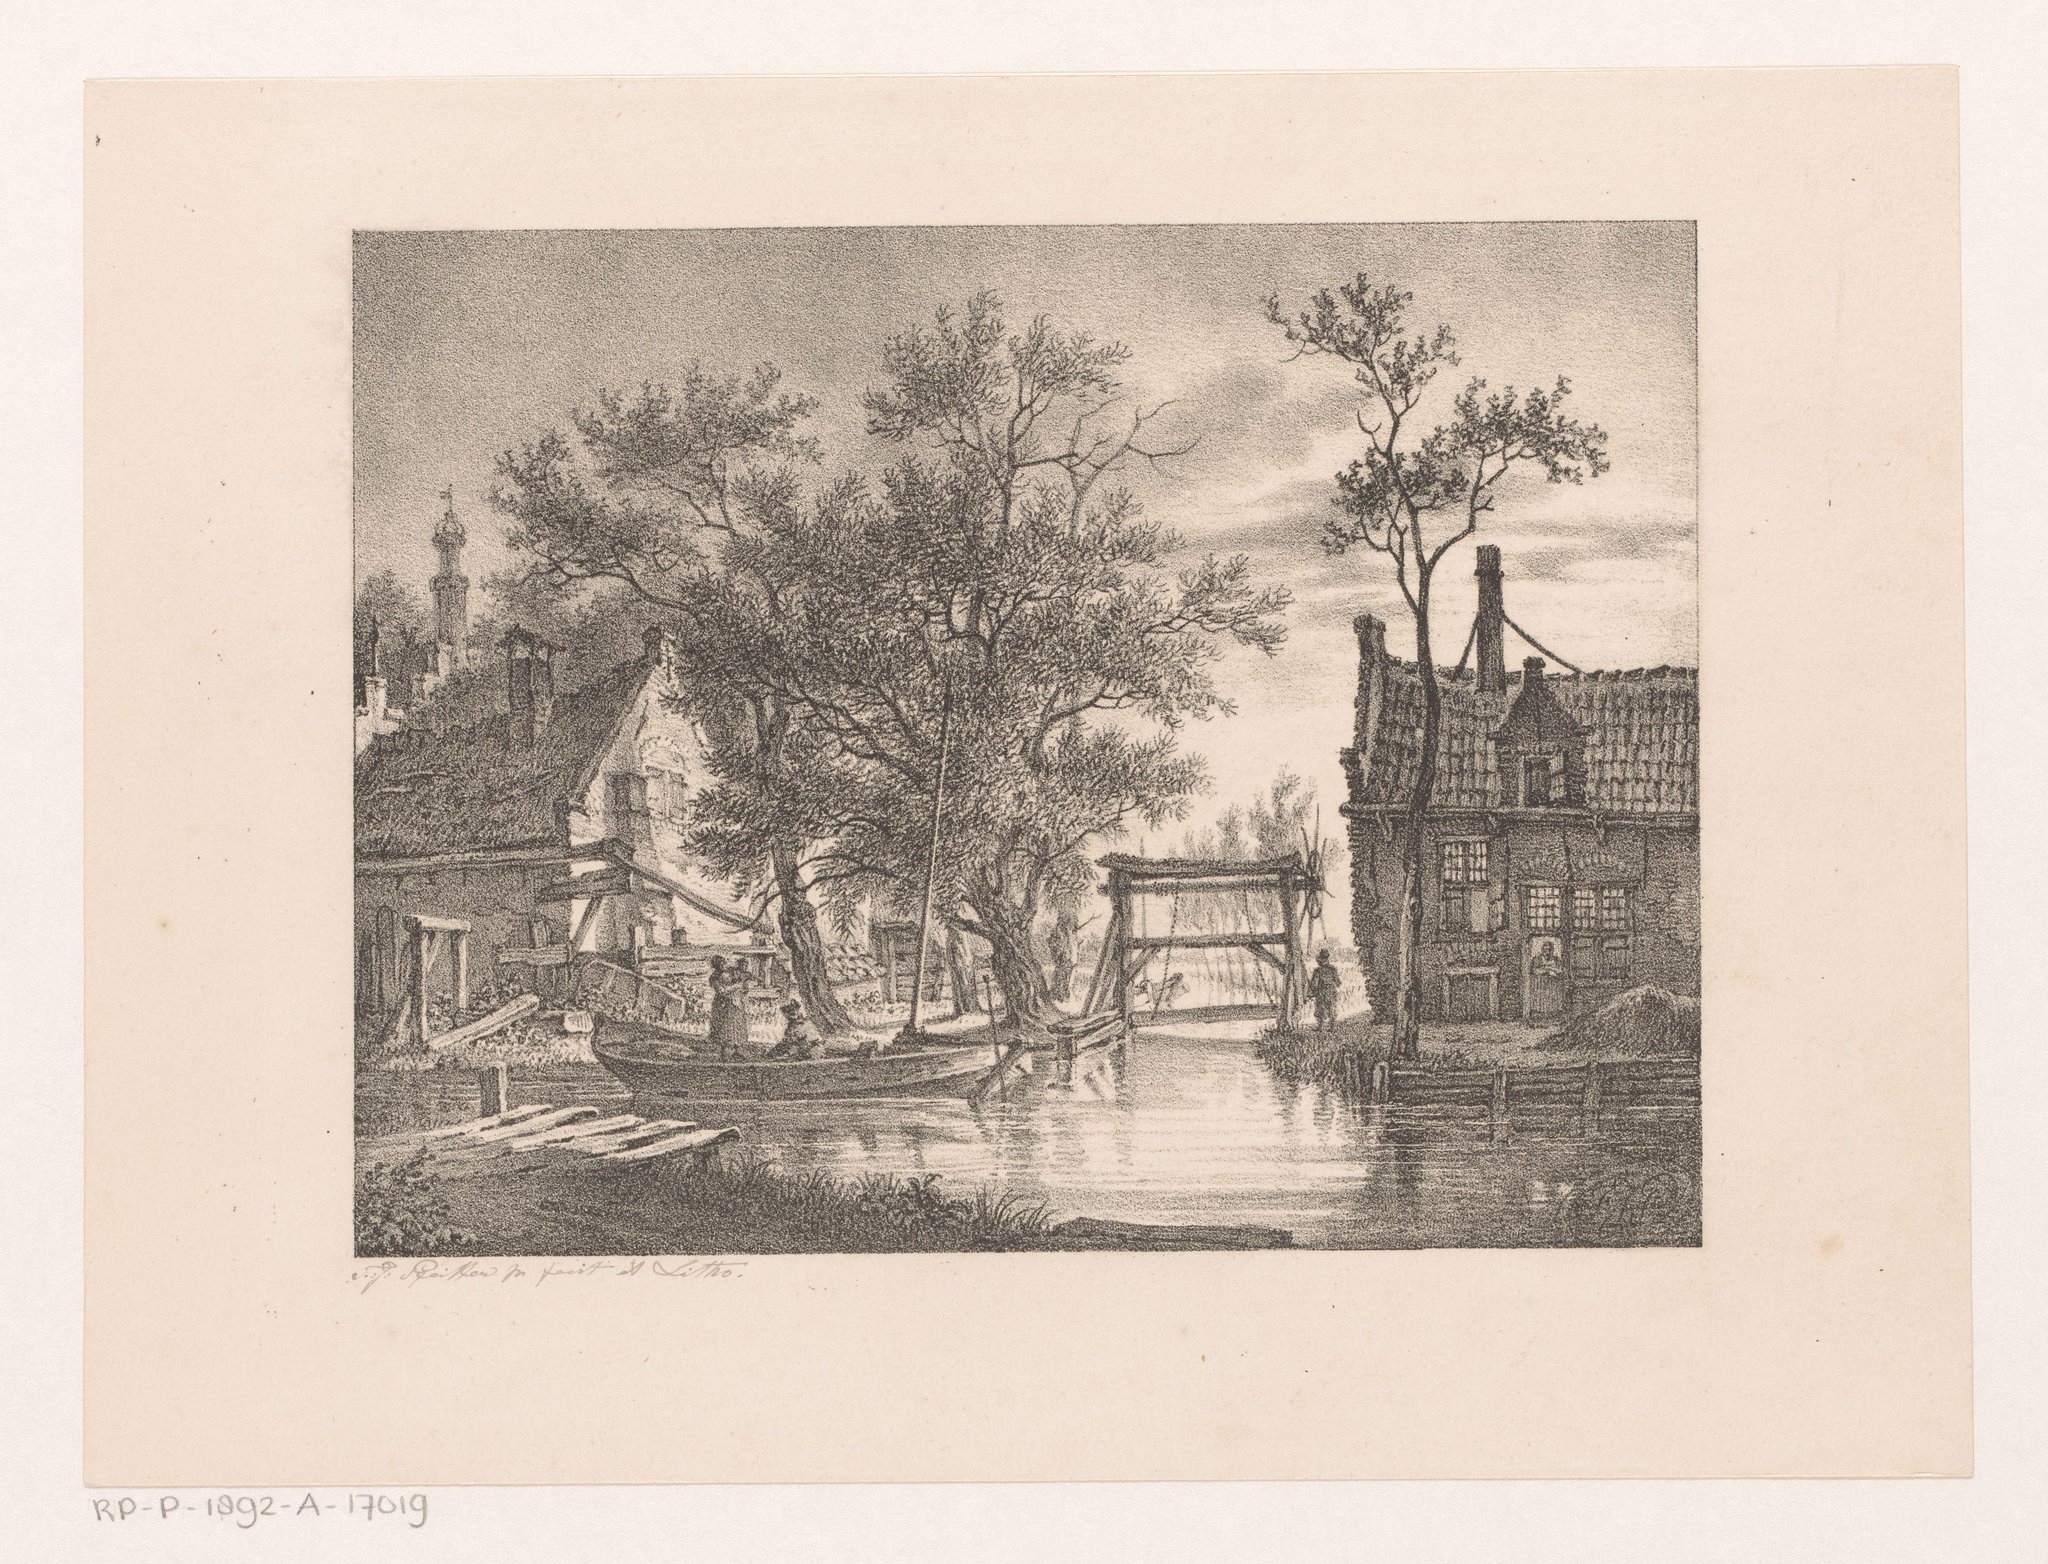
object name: print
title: Huizen aan een wetering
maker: françois joseph pfeiffer (ii)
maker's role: draughtsman, print maker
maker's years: 1778-1835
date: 1809-1835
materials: paper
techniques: lithograph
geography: amsterdam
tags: sluice, weir, water course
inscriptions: collector's mark: Lugt 2228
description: Dorpsgezicht met huizen aan het water met een sluis. Op het water vaart een boot.